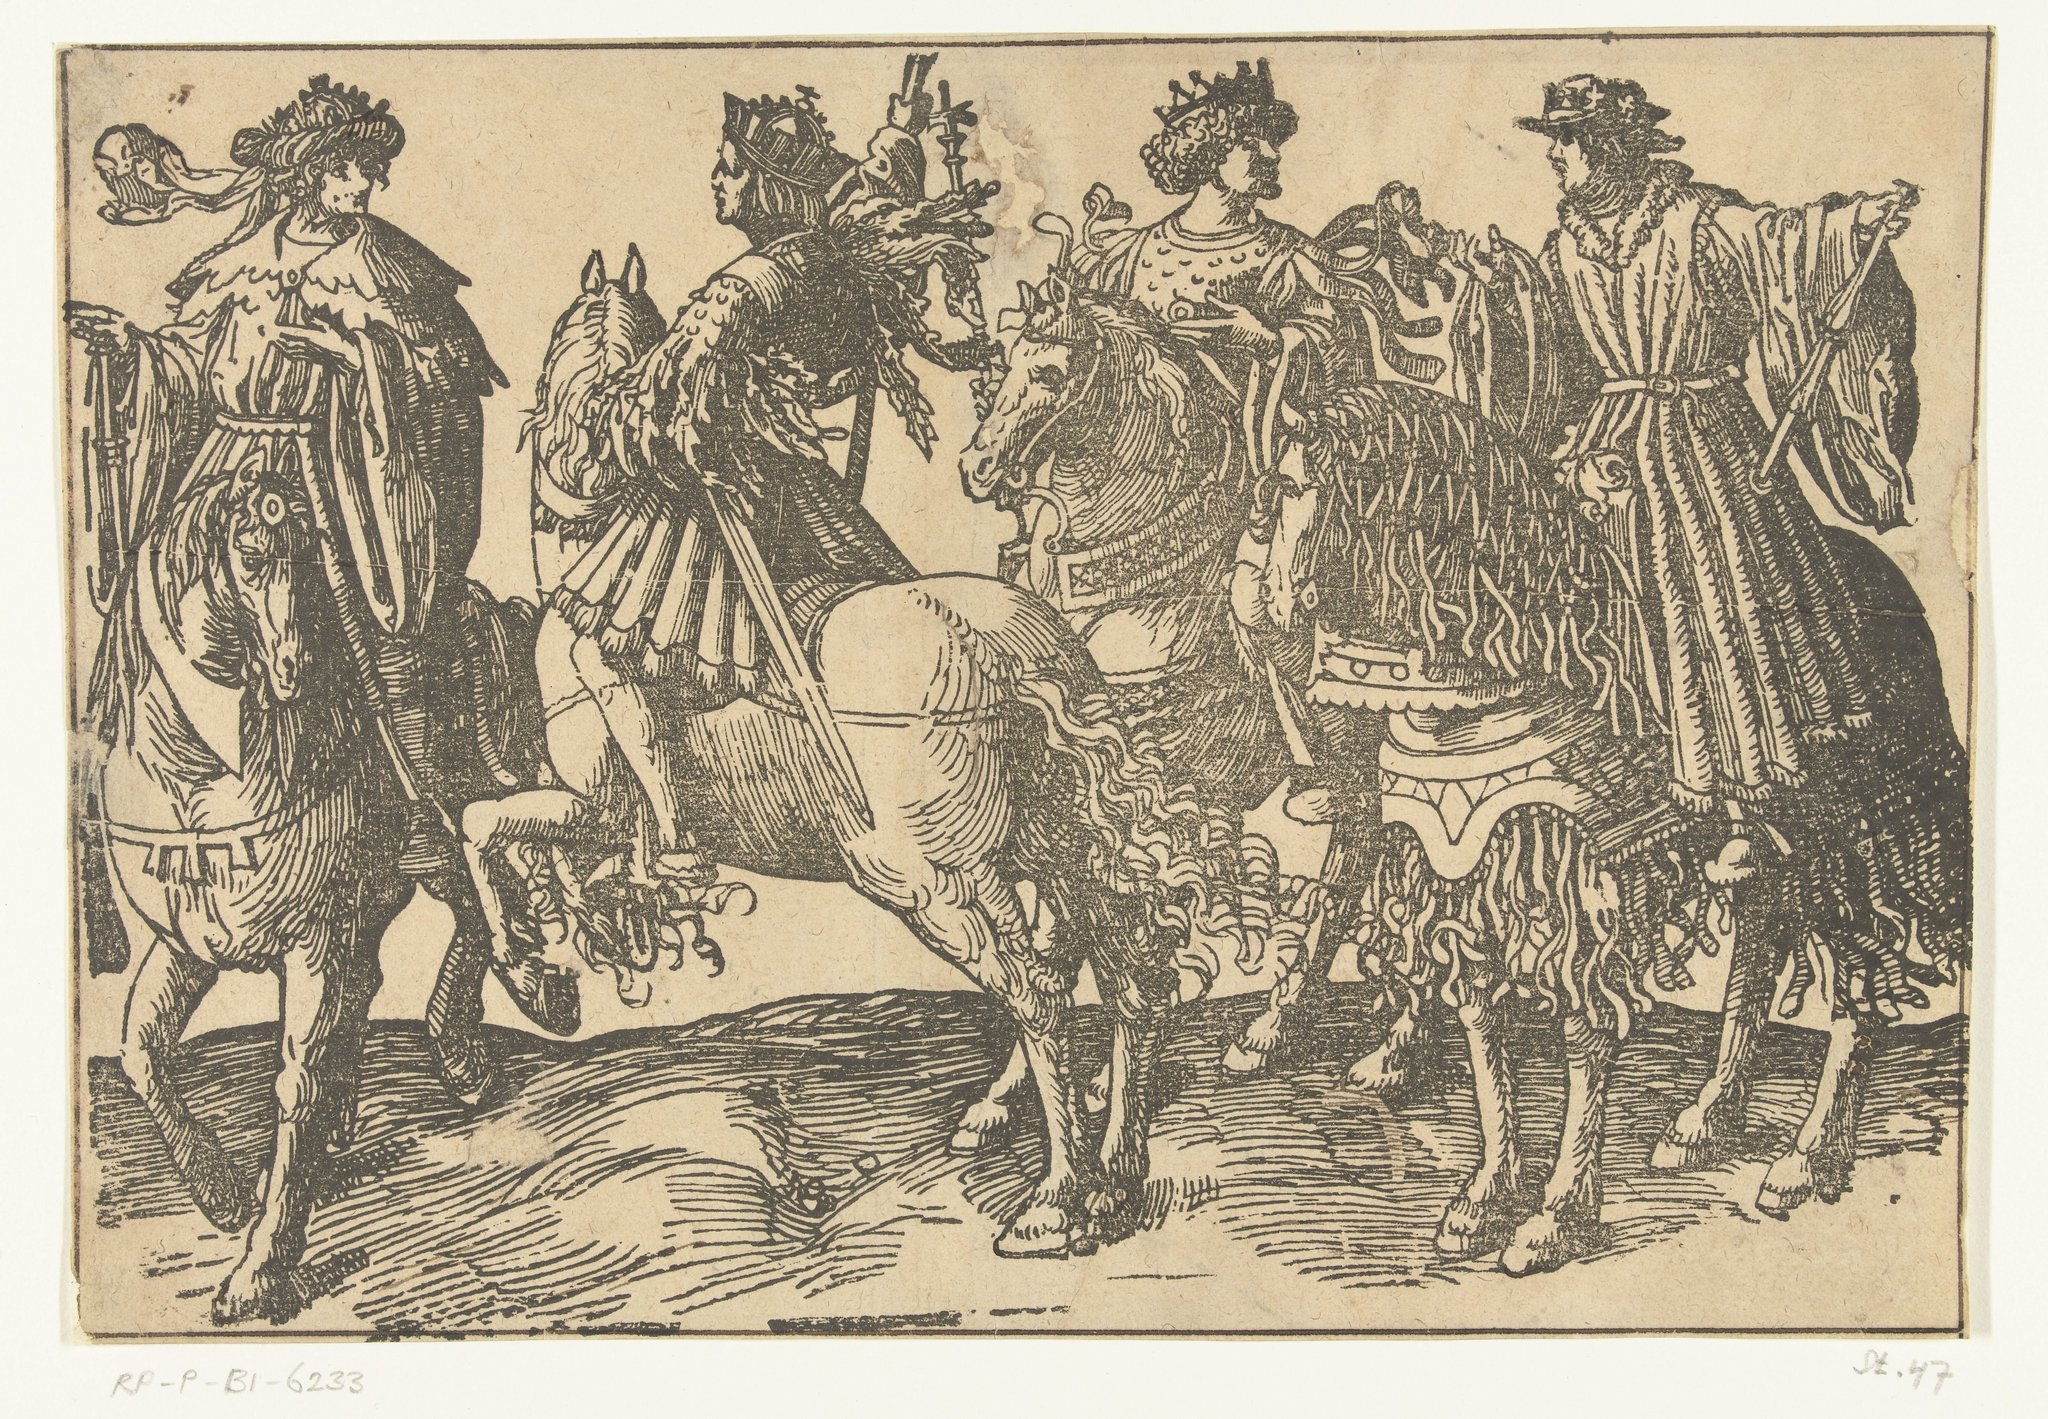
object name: print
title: Een groep van vier ruiters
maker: jacob cornelisz van oostsanen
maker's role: draughtsman, painter, print maker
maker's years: 1475-1533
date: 1518-1533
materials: paper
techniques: woodcut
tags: riding a horse, ass, or mule; rider, horseman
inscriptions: collector's mark: Lugt 240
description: Afdruk van een versneden houtblok. Vier niet geïdentificeren personen te paard. Misschien toegevoegd aan de serie Graven en Gravinnen van Holland.